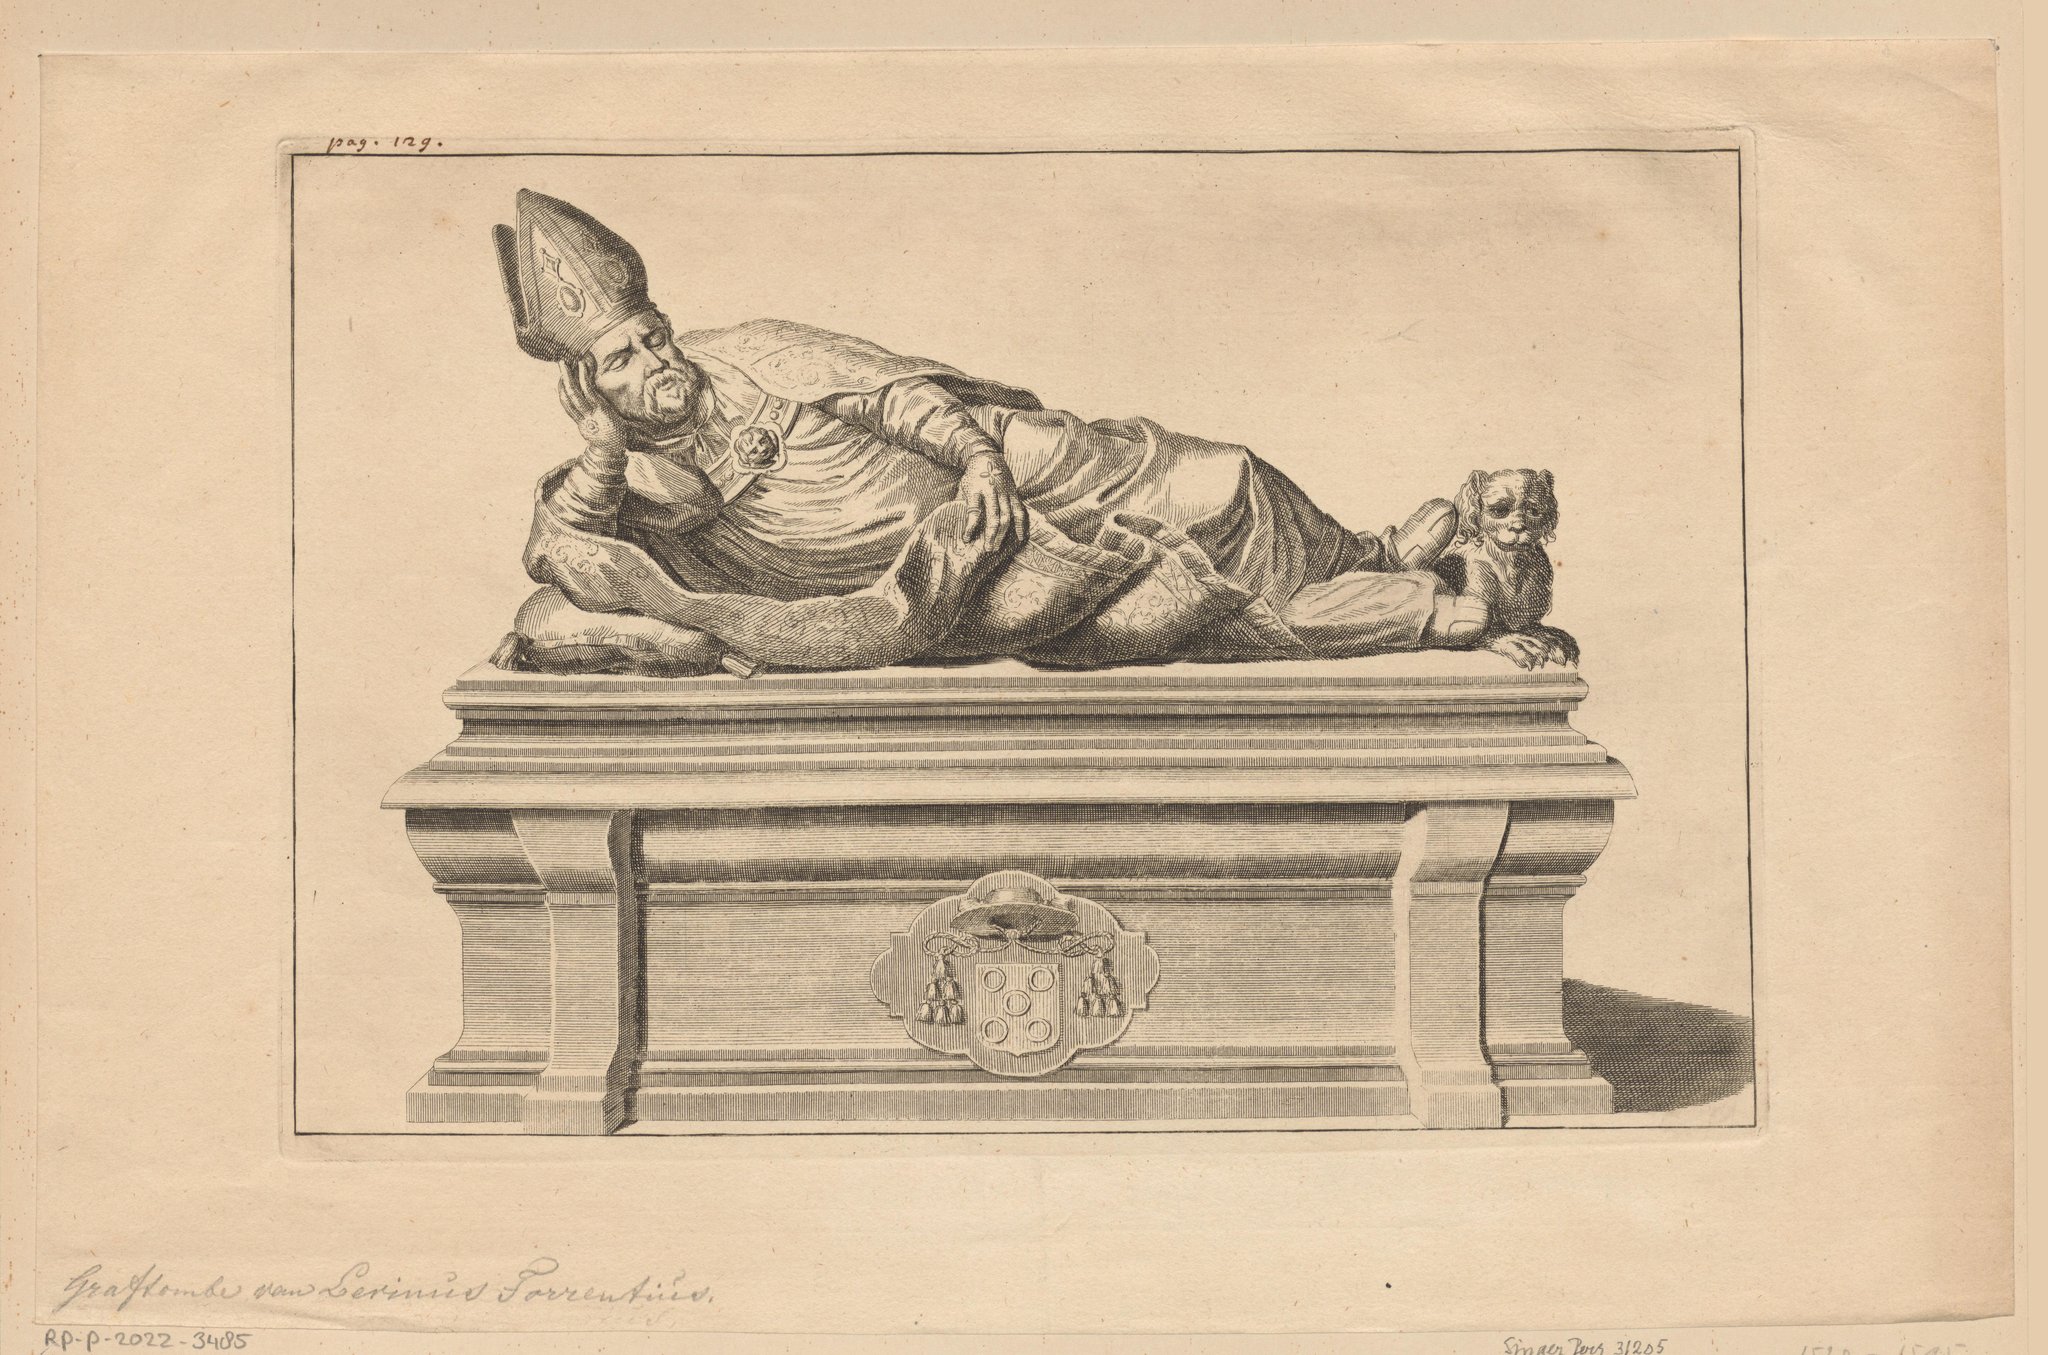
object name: print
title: Graftombe van Laevinus Torrentius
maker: Anonymous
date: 1650-1750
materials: paper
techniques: etching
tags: ghent, brussels, laevinus torrentius, archbishop, bishop, etc. (roman catholic), grave-building, monumental tomb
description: Linksboven handgeschreven genummerd: pag. 129.